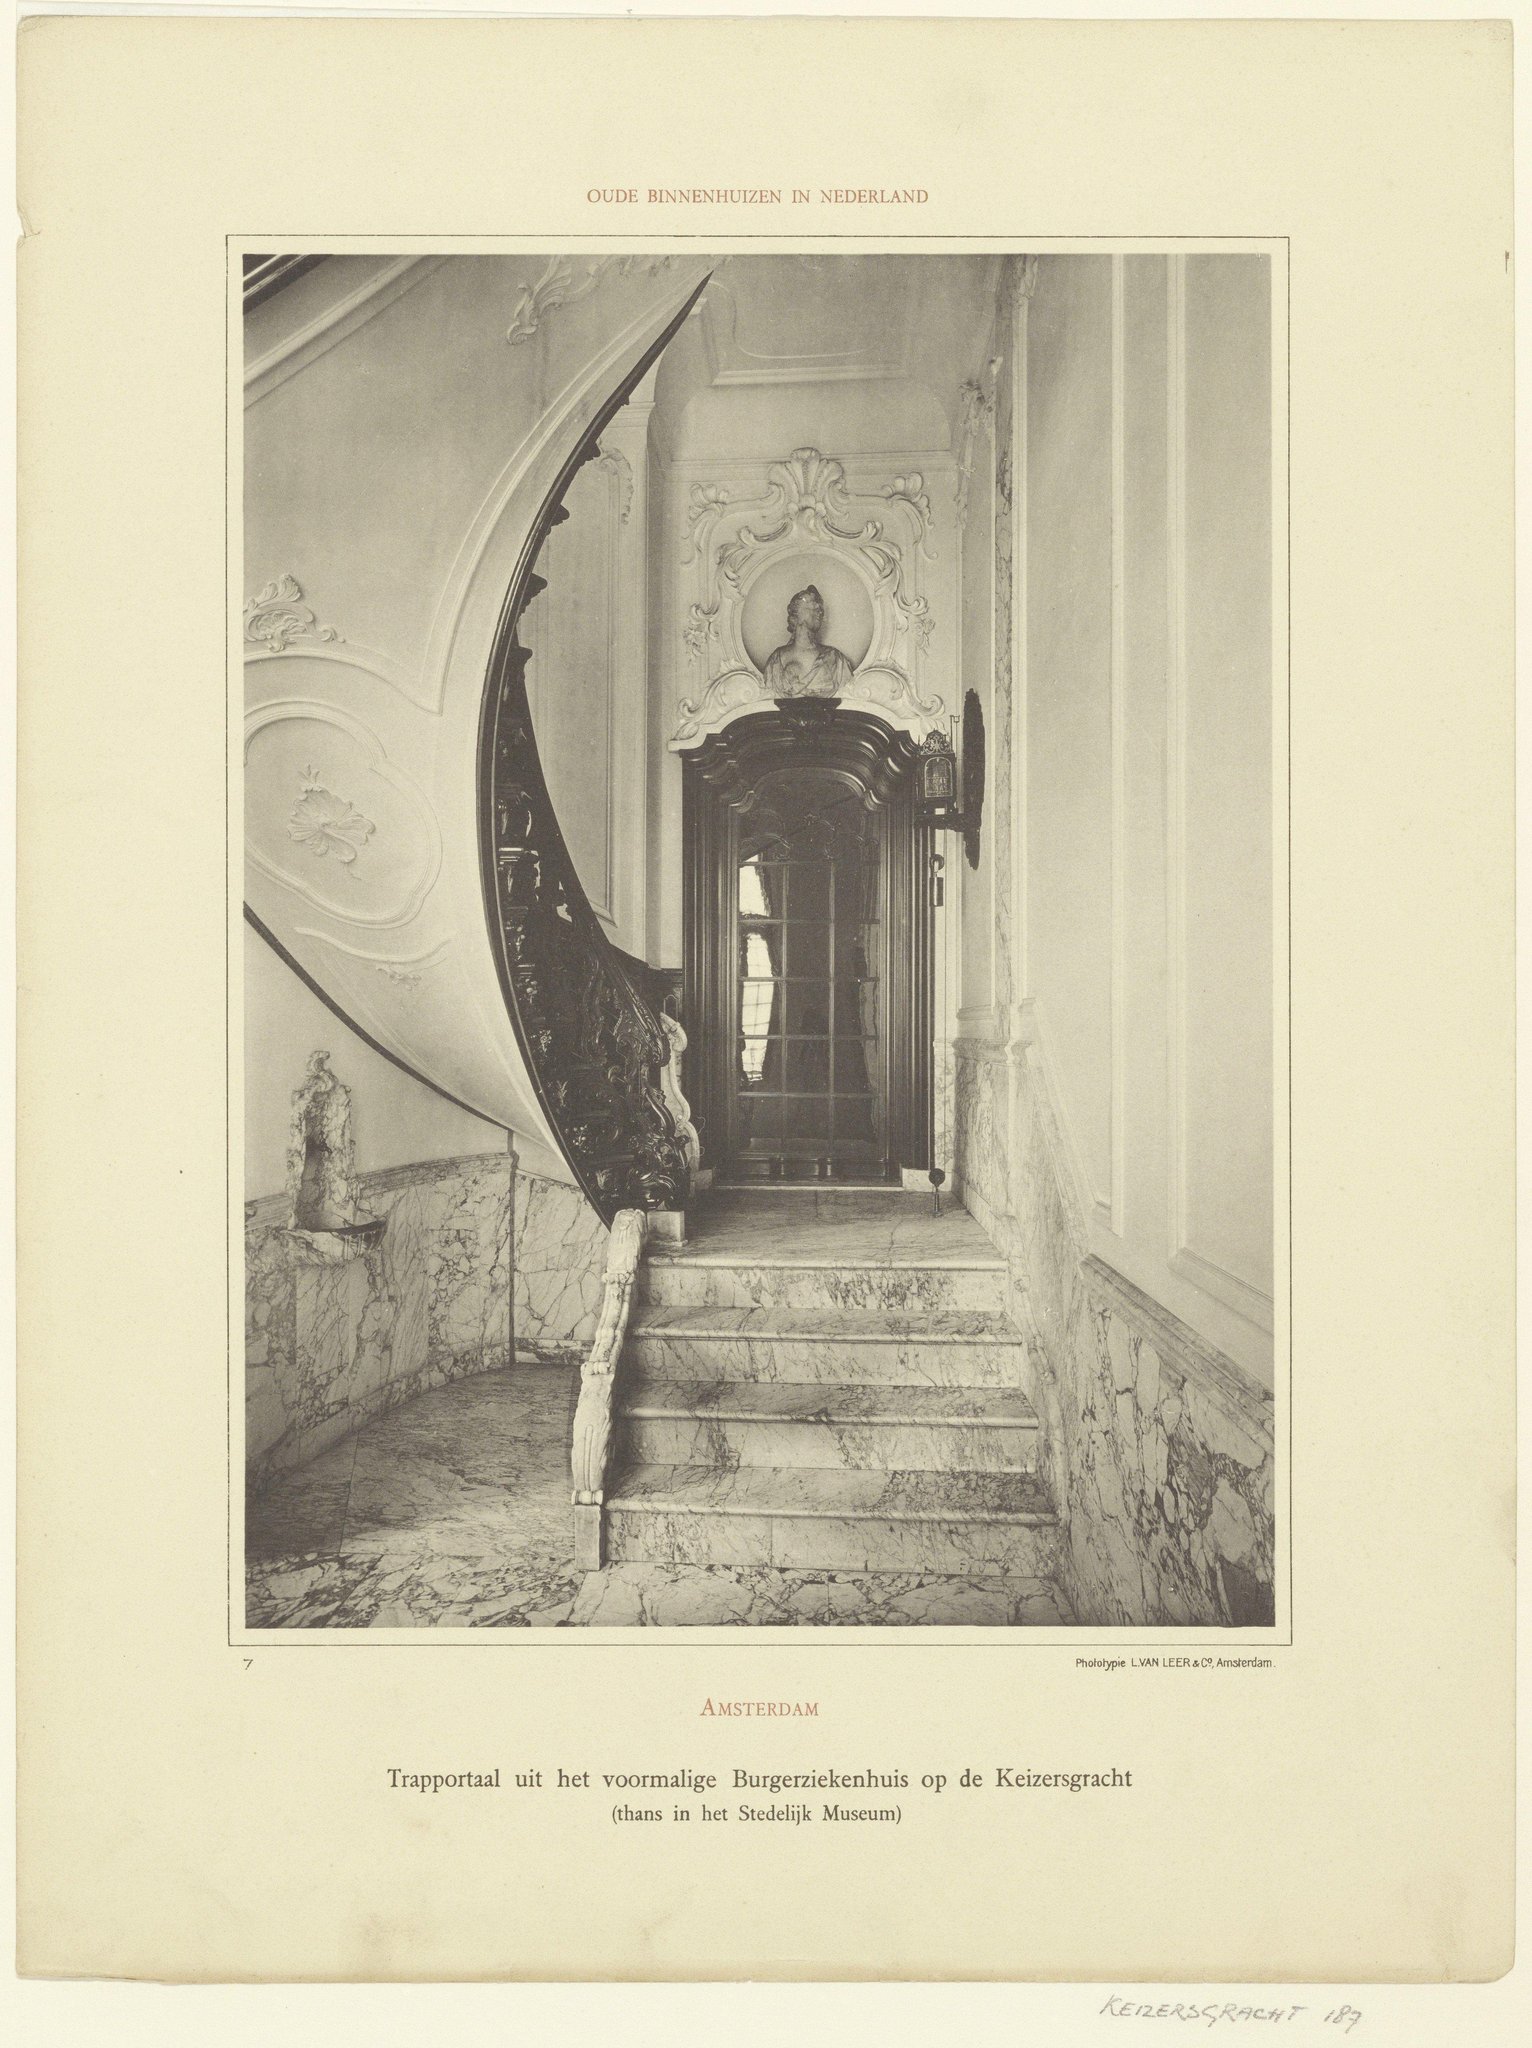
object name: architectural element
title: Onderdelen van het trapportaal uit het pand aan de Keizersgracht 187 te Amsterdam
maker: Anonymous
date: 1740-1760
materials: wood, marble